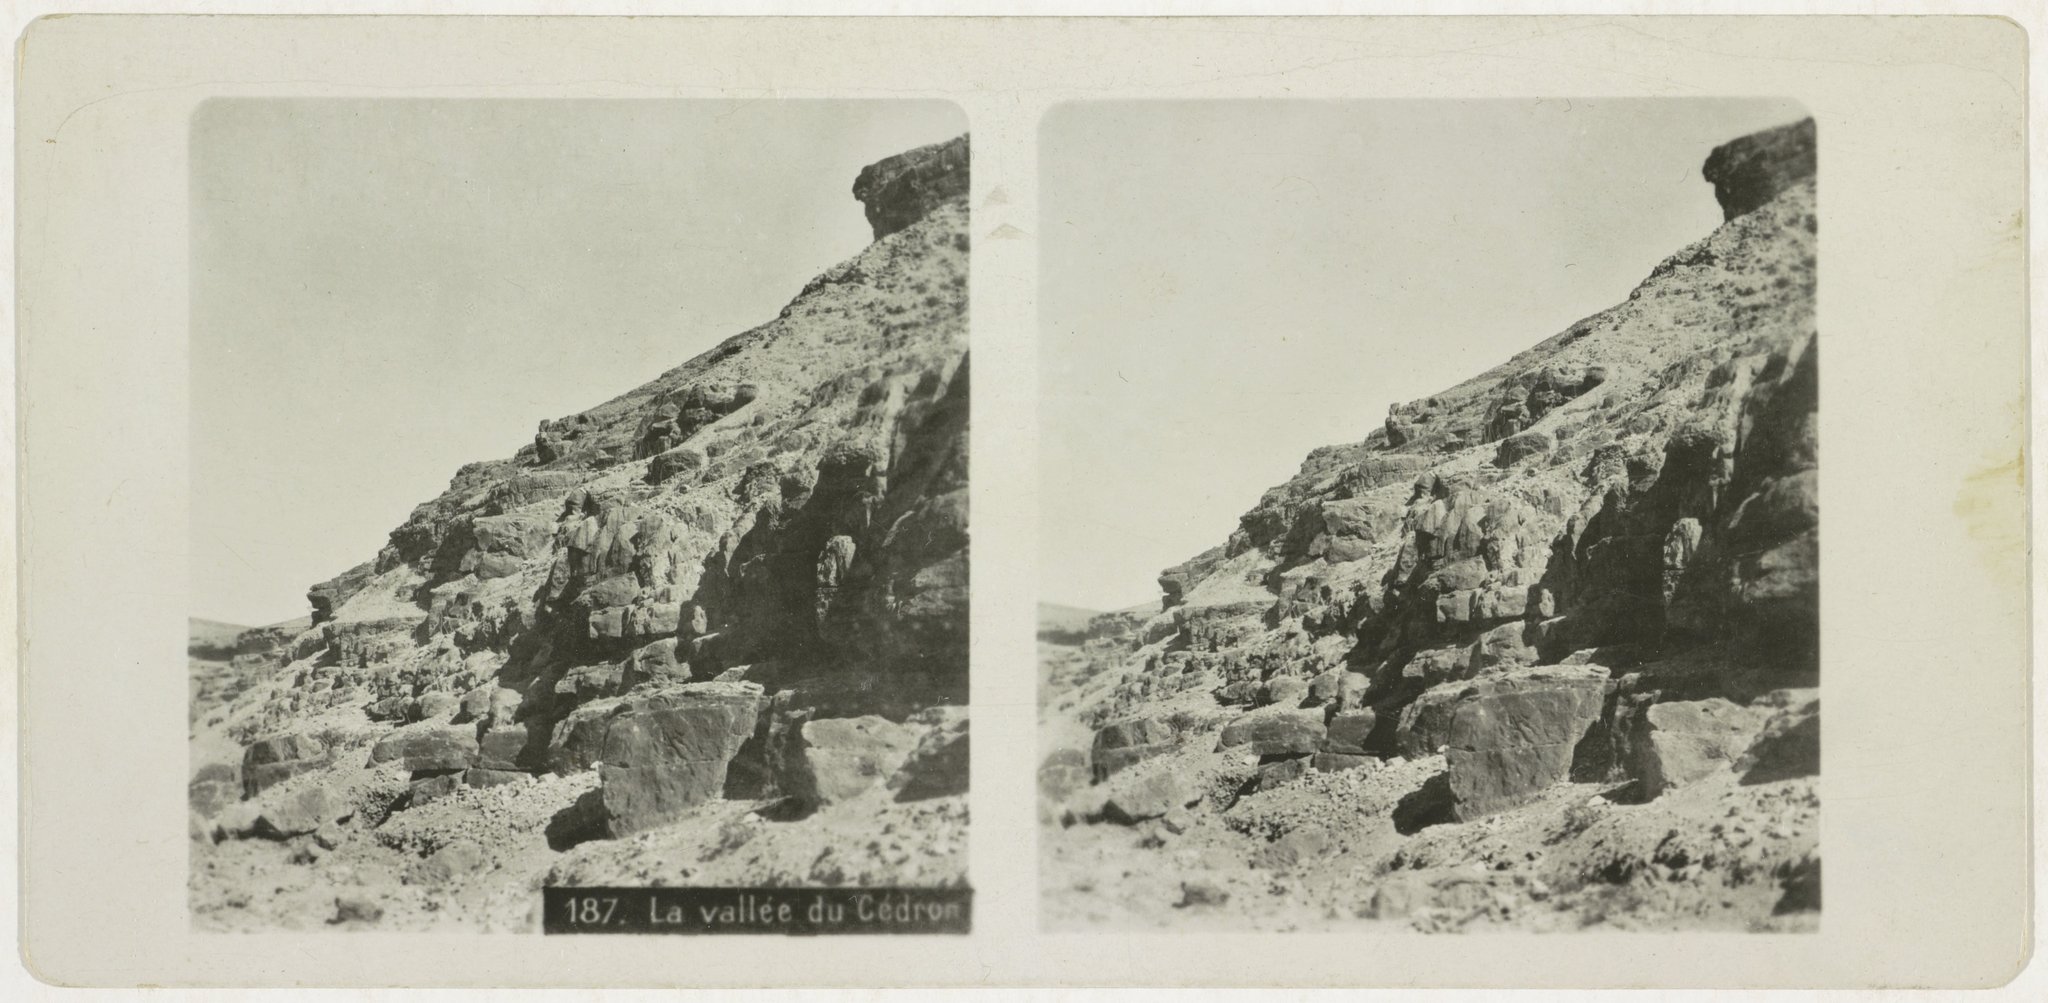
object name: stereograph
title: Collection wereld-tourist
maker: richard sochor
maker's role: painter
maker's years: 1867-1925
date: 1903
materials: paper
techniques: gelatin silver print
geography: haarlem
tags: dale, valley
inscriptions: number: ‘187.’, inscription: ‘Deze stereo-foto's worden in den handel gebracht en en gros en/ en détail verkocht door de ......... (...)’, monogram, address: ‘Parklaan 49/ HAARLEM/ (Holland)’, inscription: ‘Déposée.’